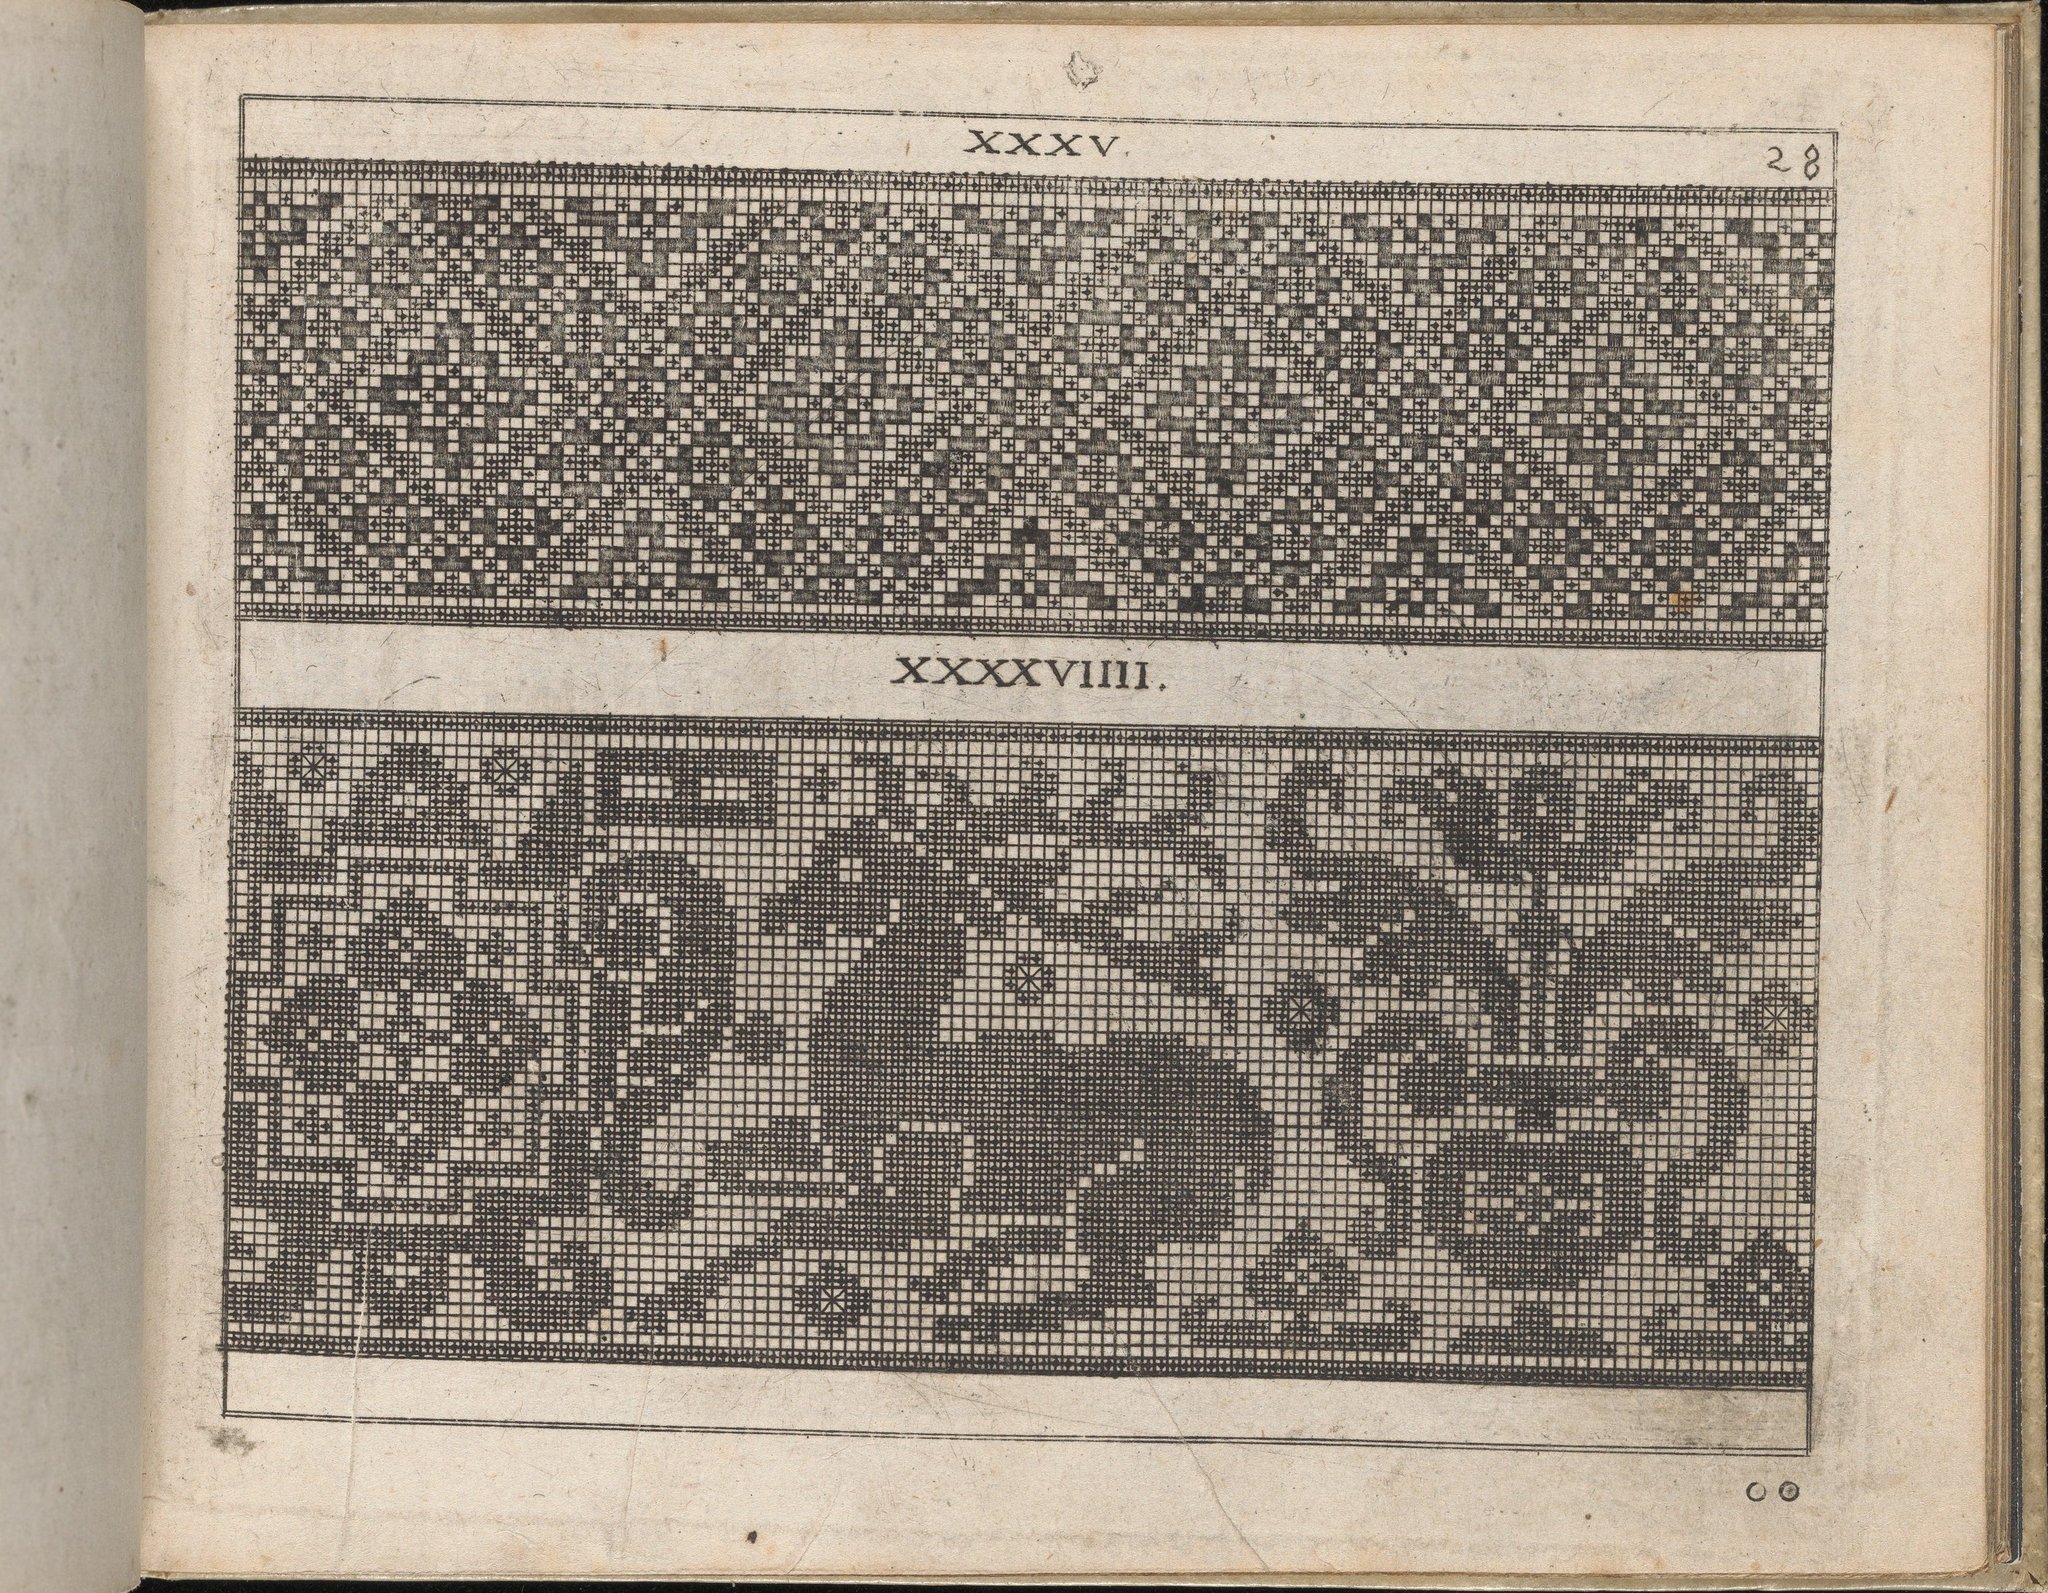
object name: book print ornament architecture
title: Newes Modelbuch in Kupffer (Page 37r)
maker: johann sibmacher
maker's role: artist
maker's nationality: german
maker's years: 1590-1611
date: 1604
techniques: etching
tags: deer